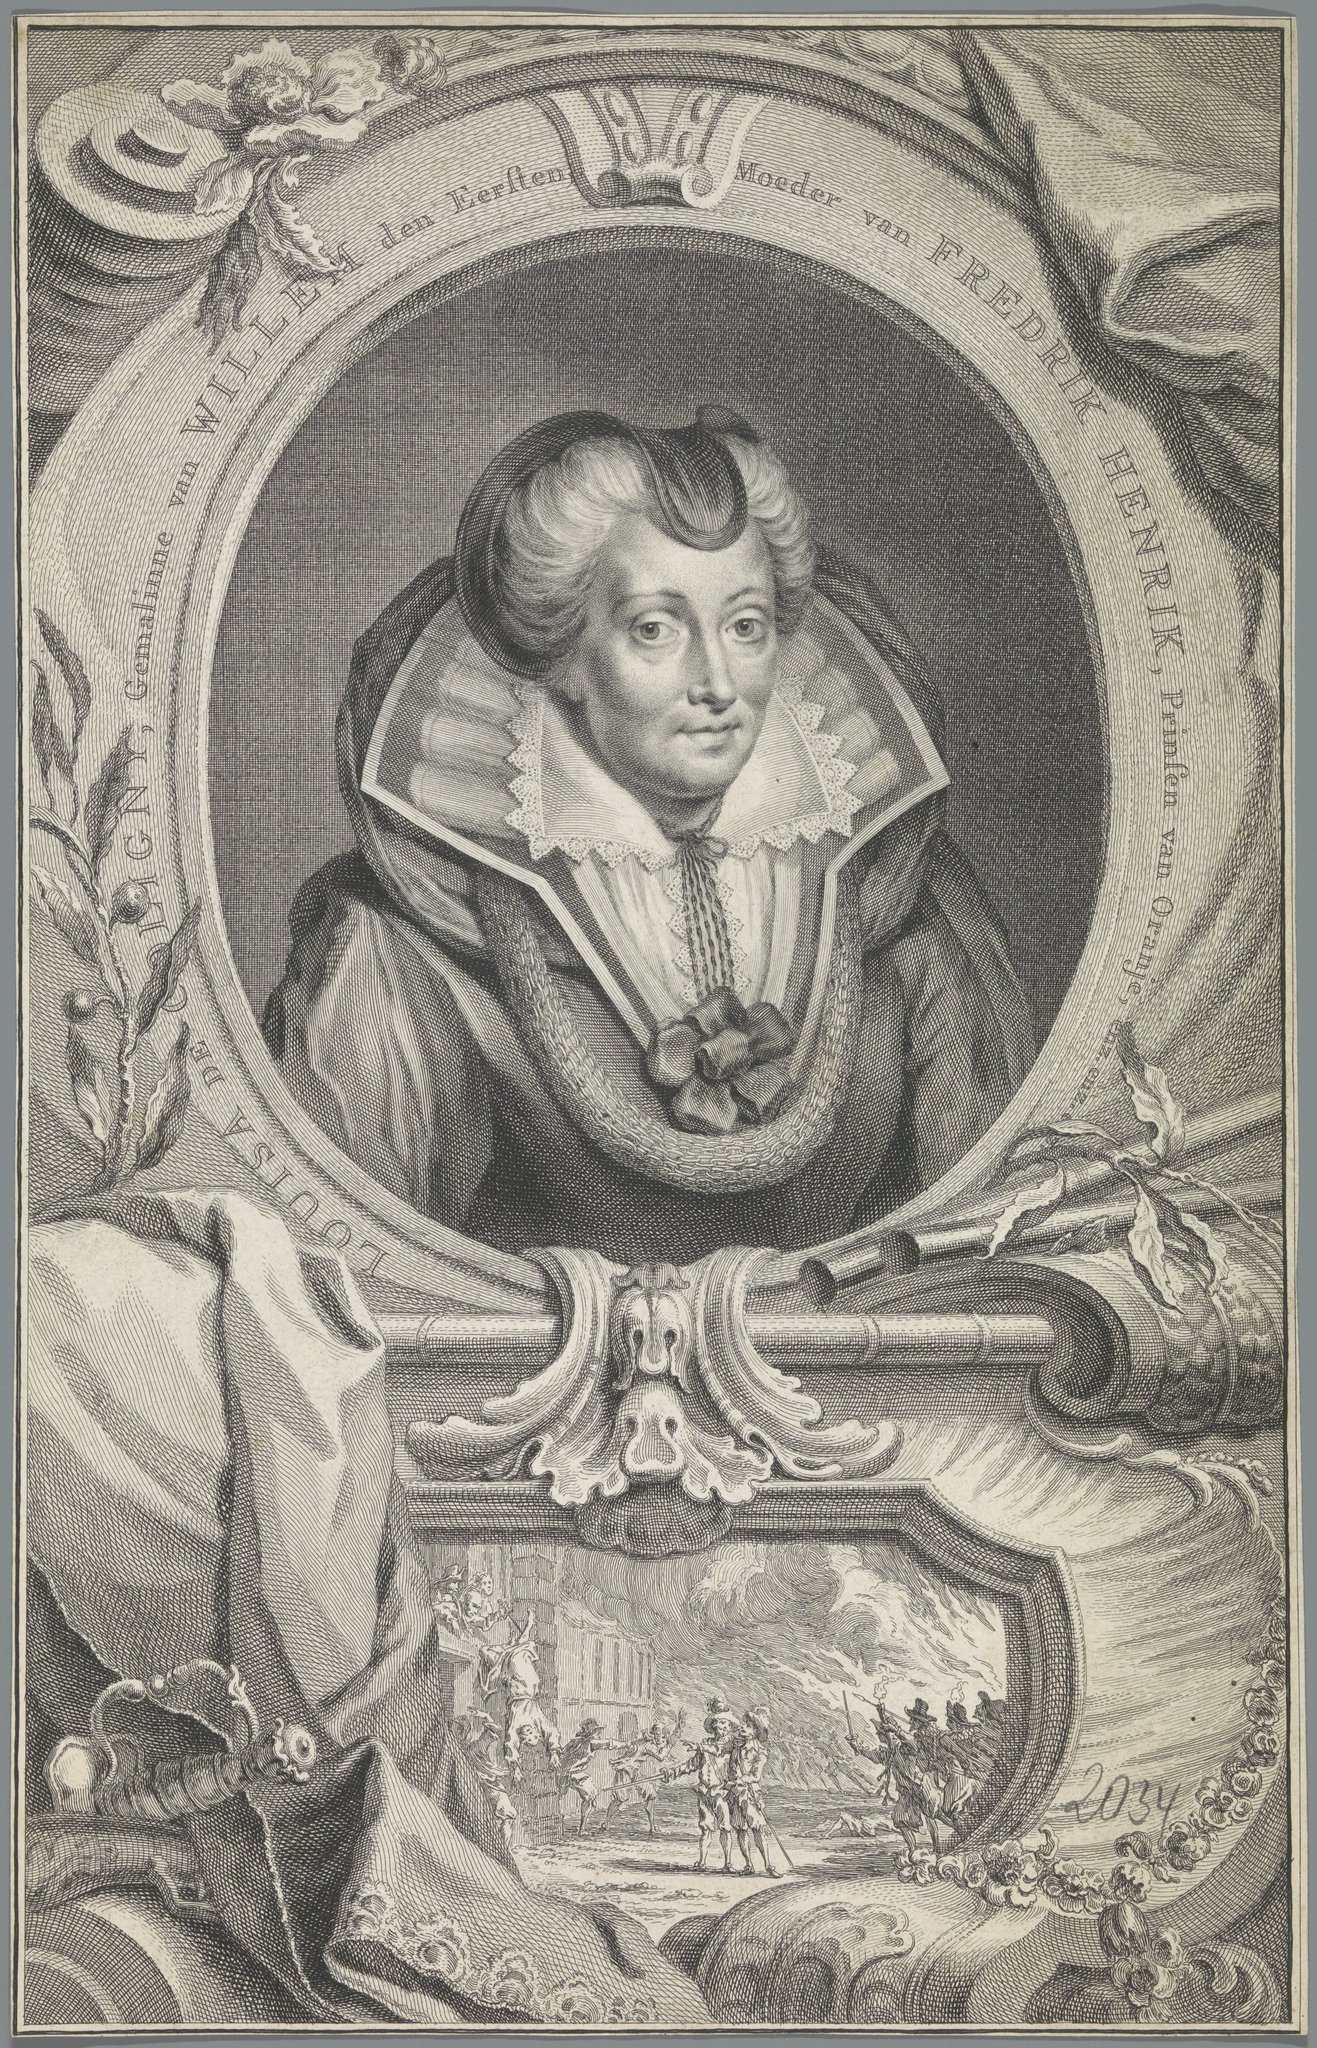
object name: print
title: Portret van Louise de Coligny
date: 1755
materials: paper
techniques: engraving, etching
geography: amsterdam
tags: louise de coligny, neck-gear: collar (+ women's clothes)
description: Portret van Louise in een ovaal met randschrift. Rondom ligt een aantal allegorische objecten. Op het reliëf een historische voorstelling.